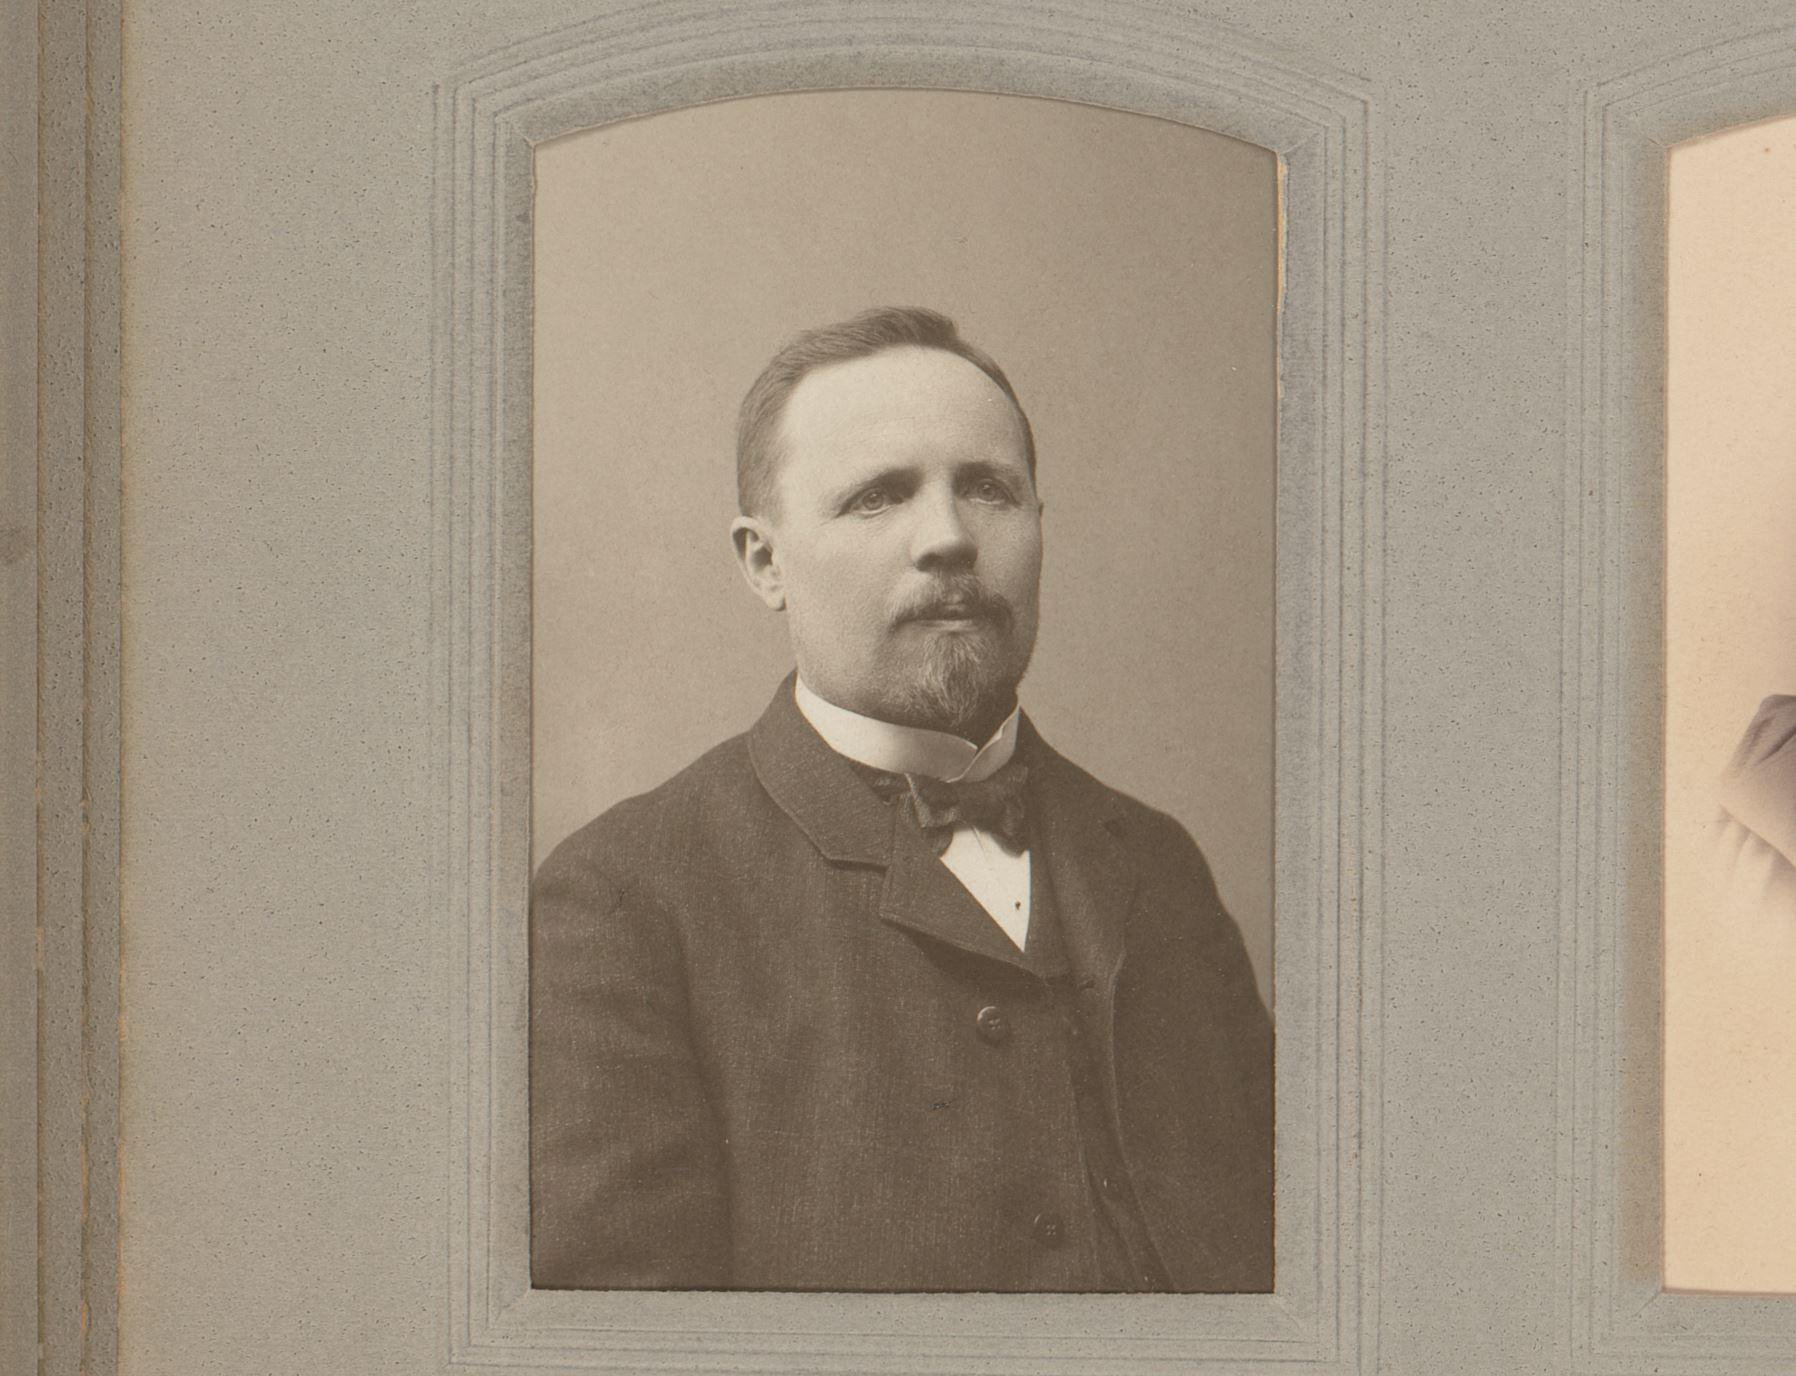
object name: carte de visite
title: Portret van een man met snor, baard en vlinderstrik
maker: gustaf lesser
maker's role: fotograaf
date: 1895-1920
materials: cardboard, photographic support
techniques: matte daylight collodion silver print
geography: eskilstuna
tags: moustache, historical persons, beard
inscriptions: inscription: ‘Gustaf Lesser/ Eskilstuna/ Atelje/ Smedjegatan 2.C./ Telefon 460./ Plåten förvaras.’